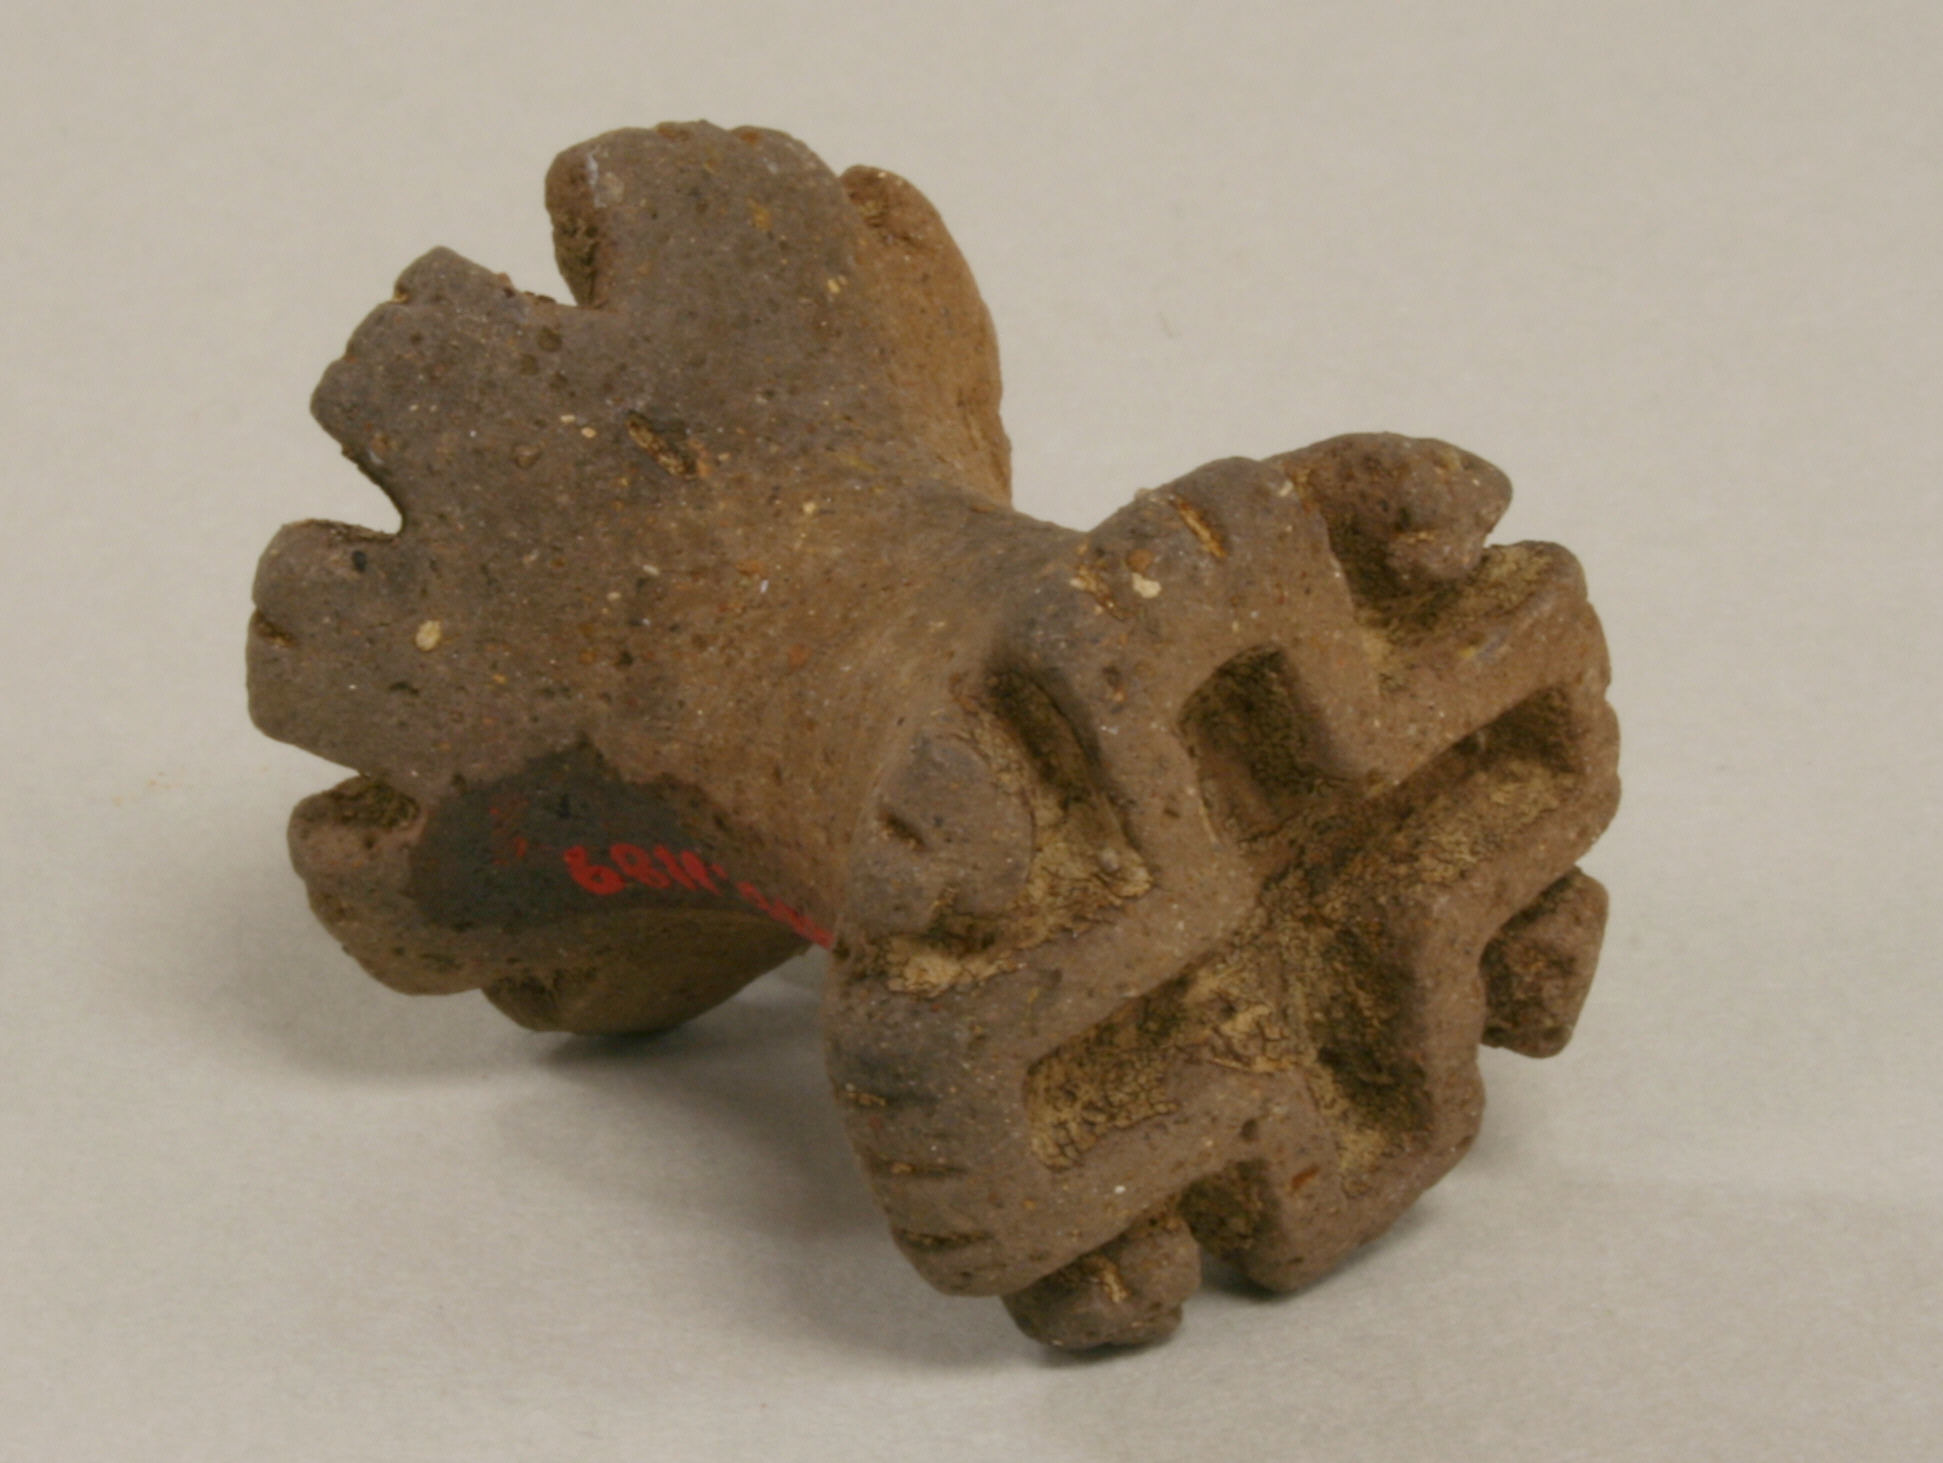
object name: stamp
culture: atlantic watershed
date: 401-600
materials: ceramic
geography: costa rica